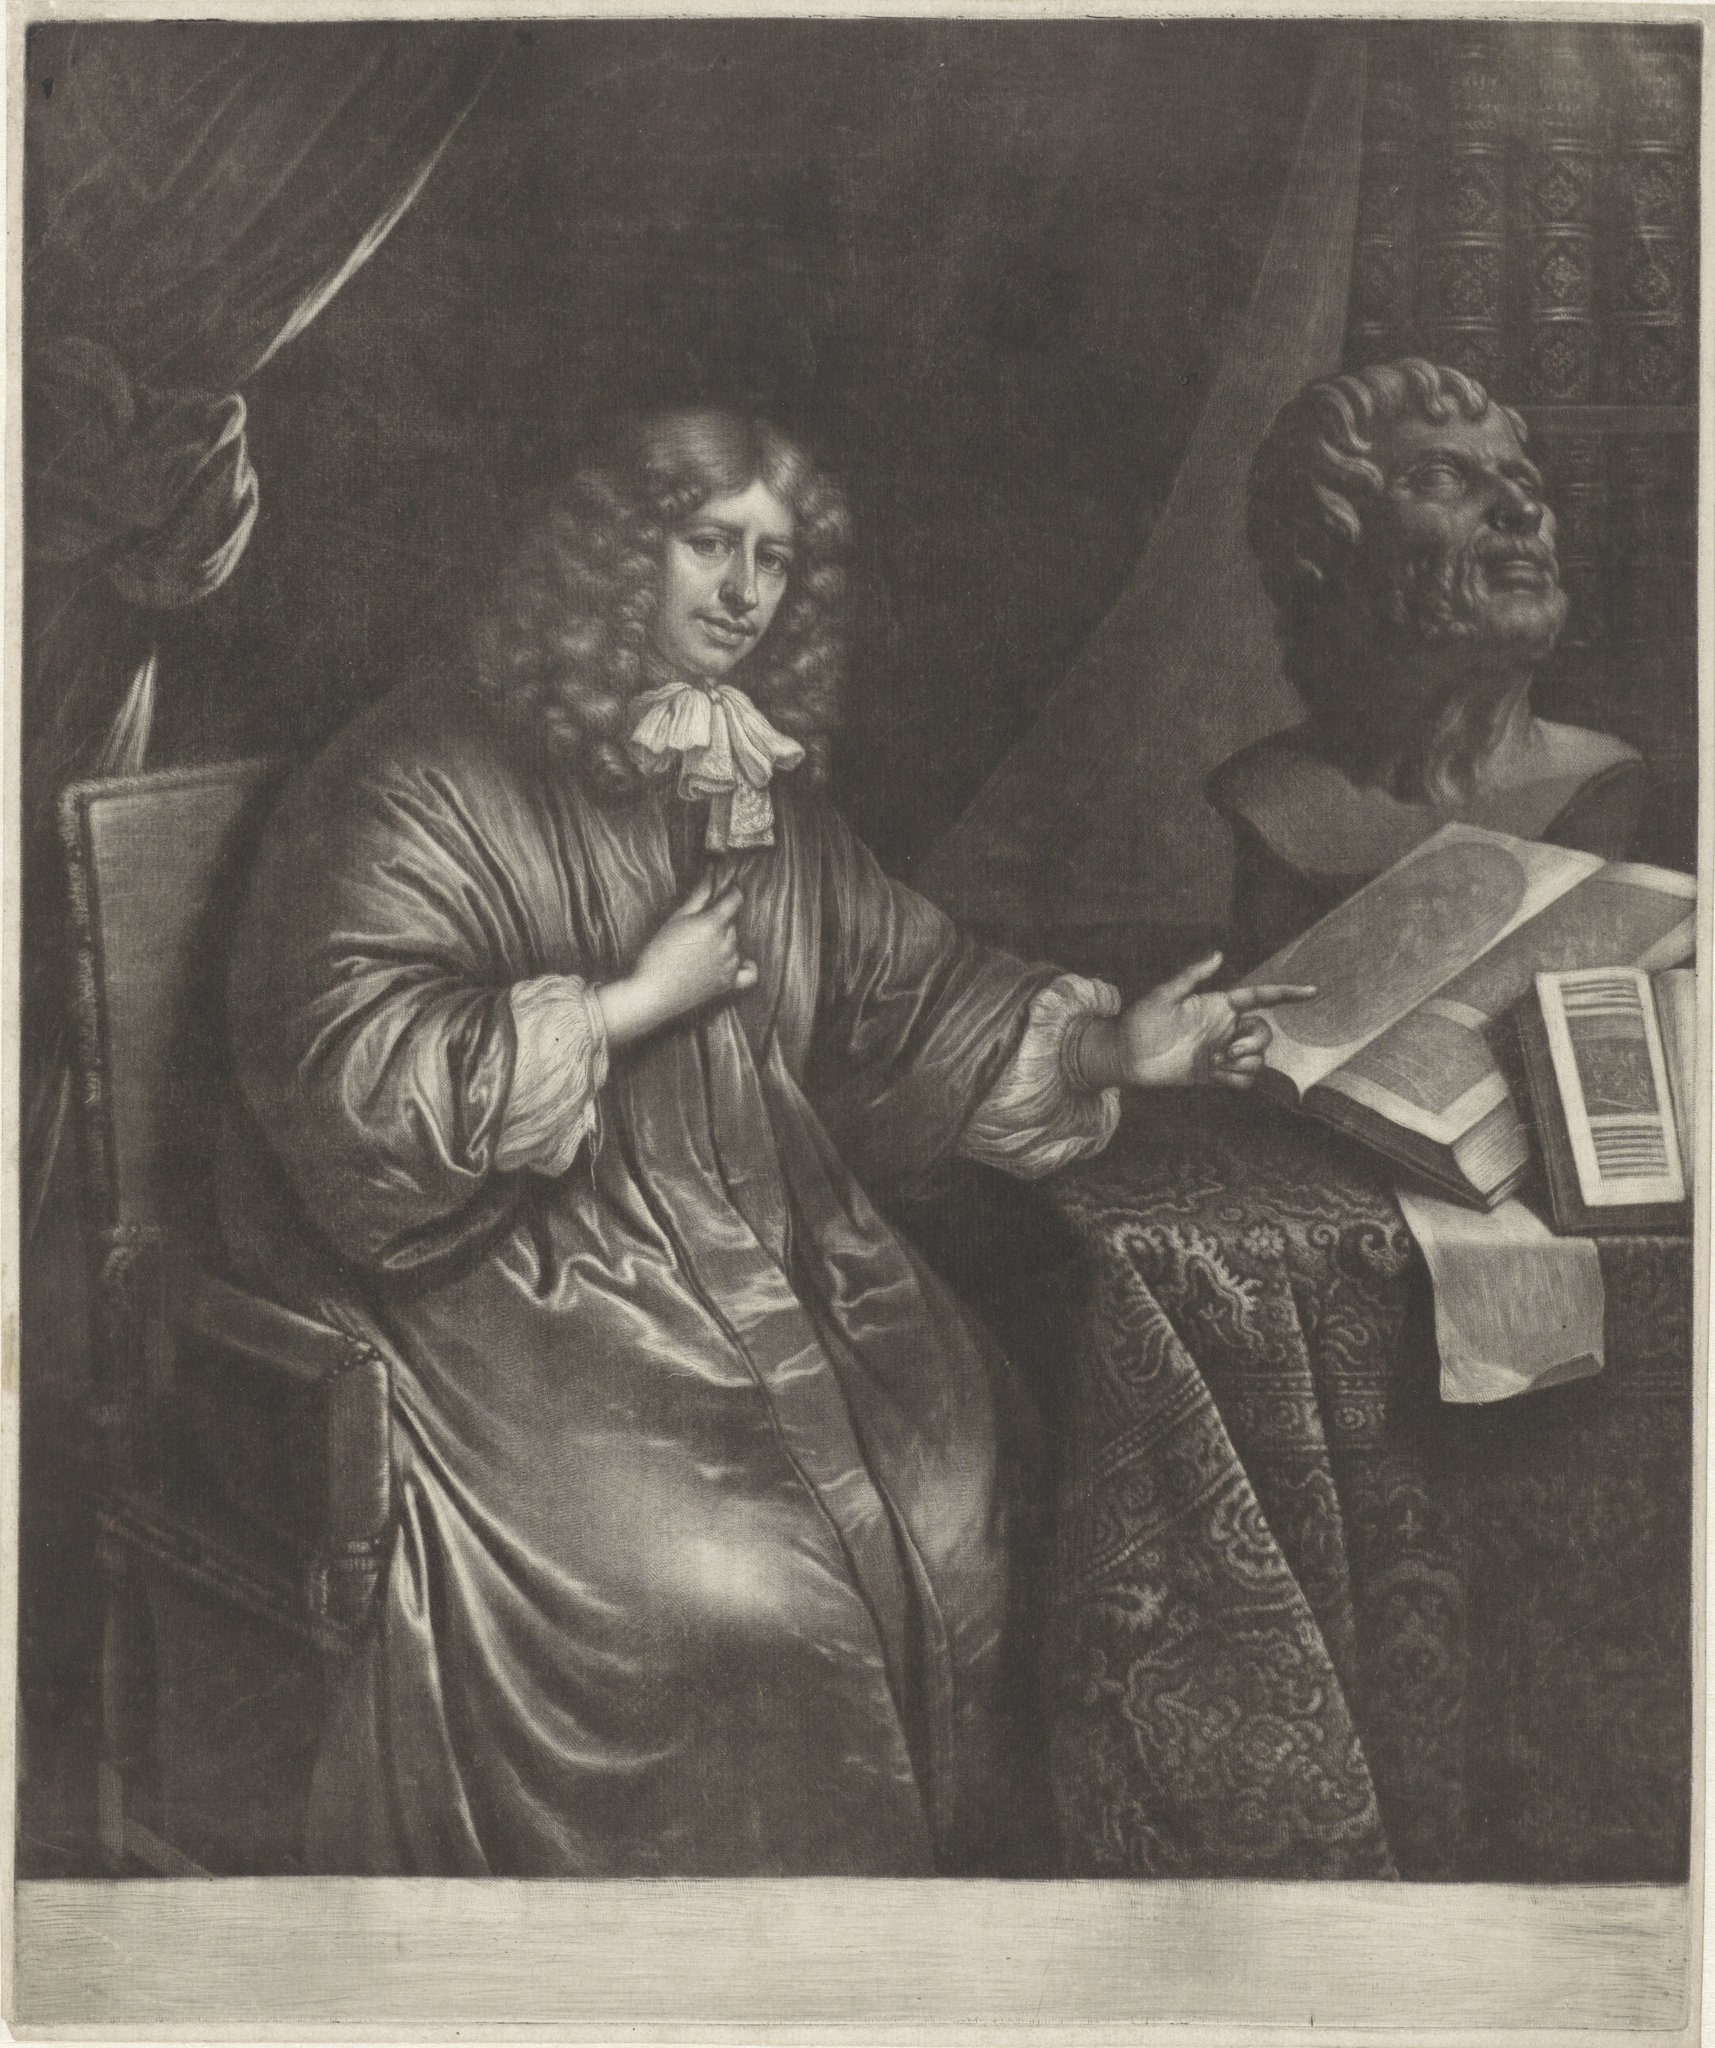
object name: print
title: Portret van Abraham van Lennep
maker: wallerant vaillant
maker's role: draughtsman, painter, print maker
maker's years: 1623-1677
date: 1672-1677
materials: paper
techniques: mezzotint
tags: print, e.g.: engraving, etching, lithograph, book - mm - book open, sculpture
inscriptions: collector's mark: Lugt 2228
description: De kunstminnaar Abraham van Lennep zit in zijn studeerkamer aan een bureau. Hij wijst op twee boeken met prenten die voor hem liggen. Naast de boeken staat een klassieke buste.